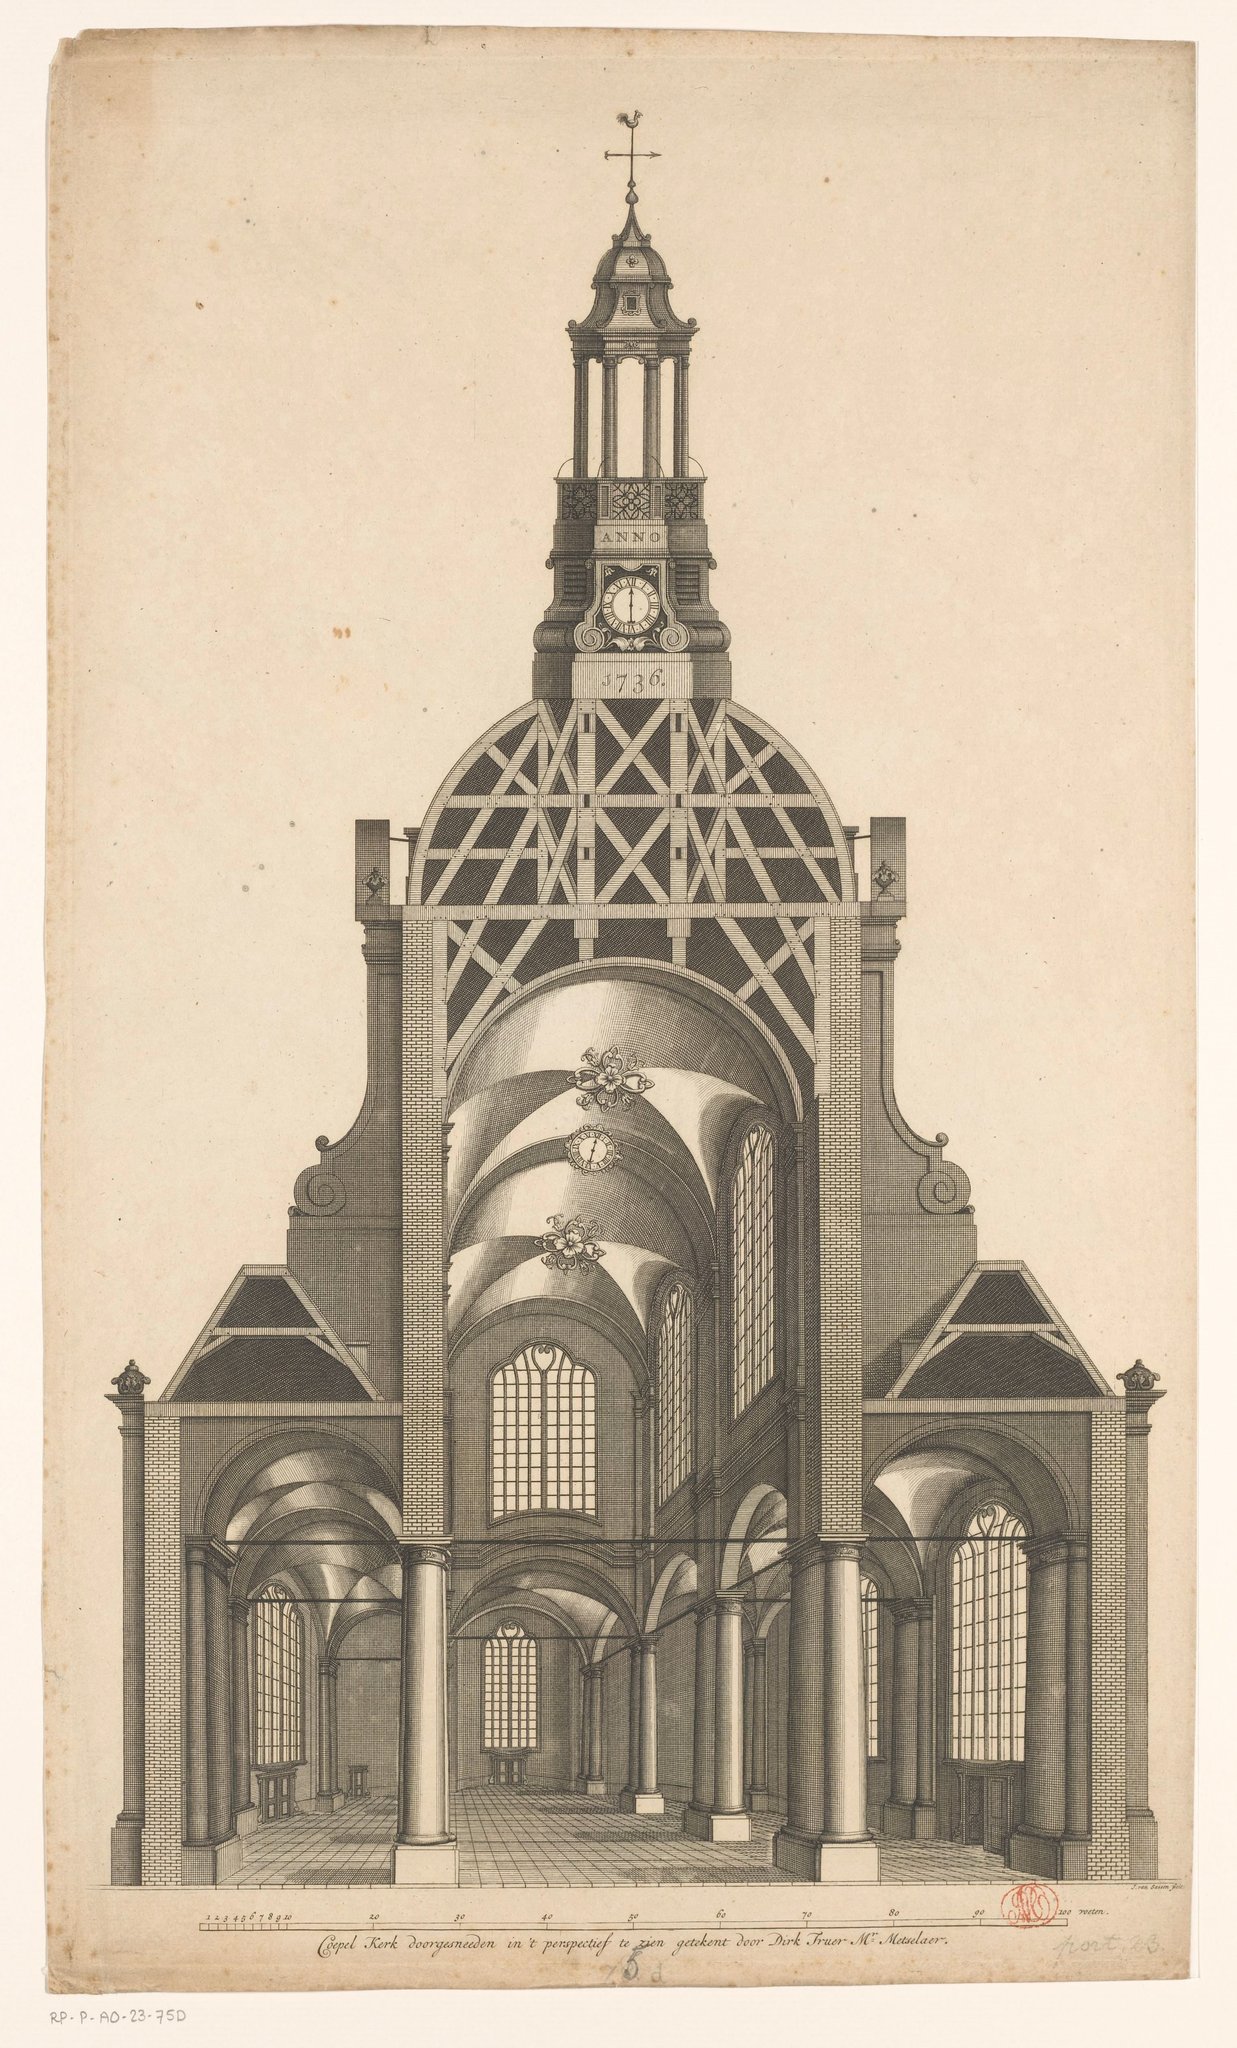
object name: design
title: Coepel Kerk doorgesneeden in 't perspectief te zien getekent door Dirk Truer Mr. Metselaer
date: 1736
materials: paper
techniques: engraving, etching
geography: amsterdam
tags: interior ~ architectural design or model, interior of church, section ~ architectural design or model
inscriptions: collector's mark: Lugt 195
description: Doorsnede van een koepelkerk voor op de Botermarkt, het huidige Rembrandtplein, te Amsterdam. Onder in het midden een schaalstok: 100 voeten. Niet uitgevoerd architectuurontwerp.